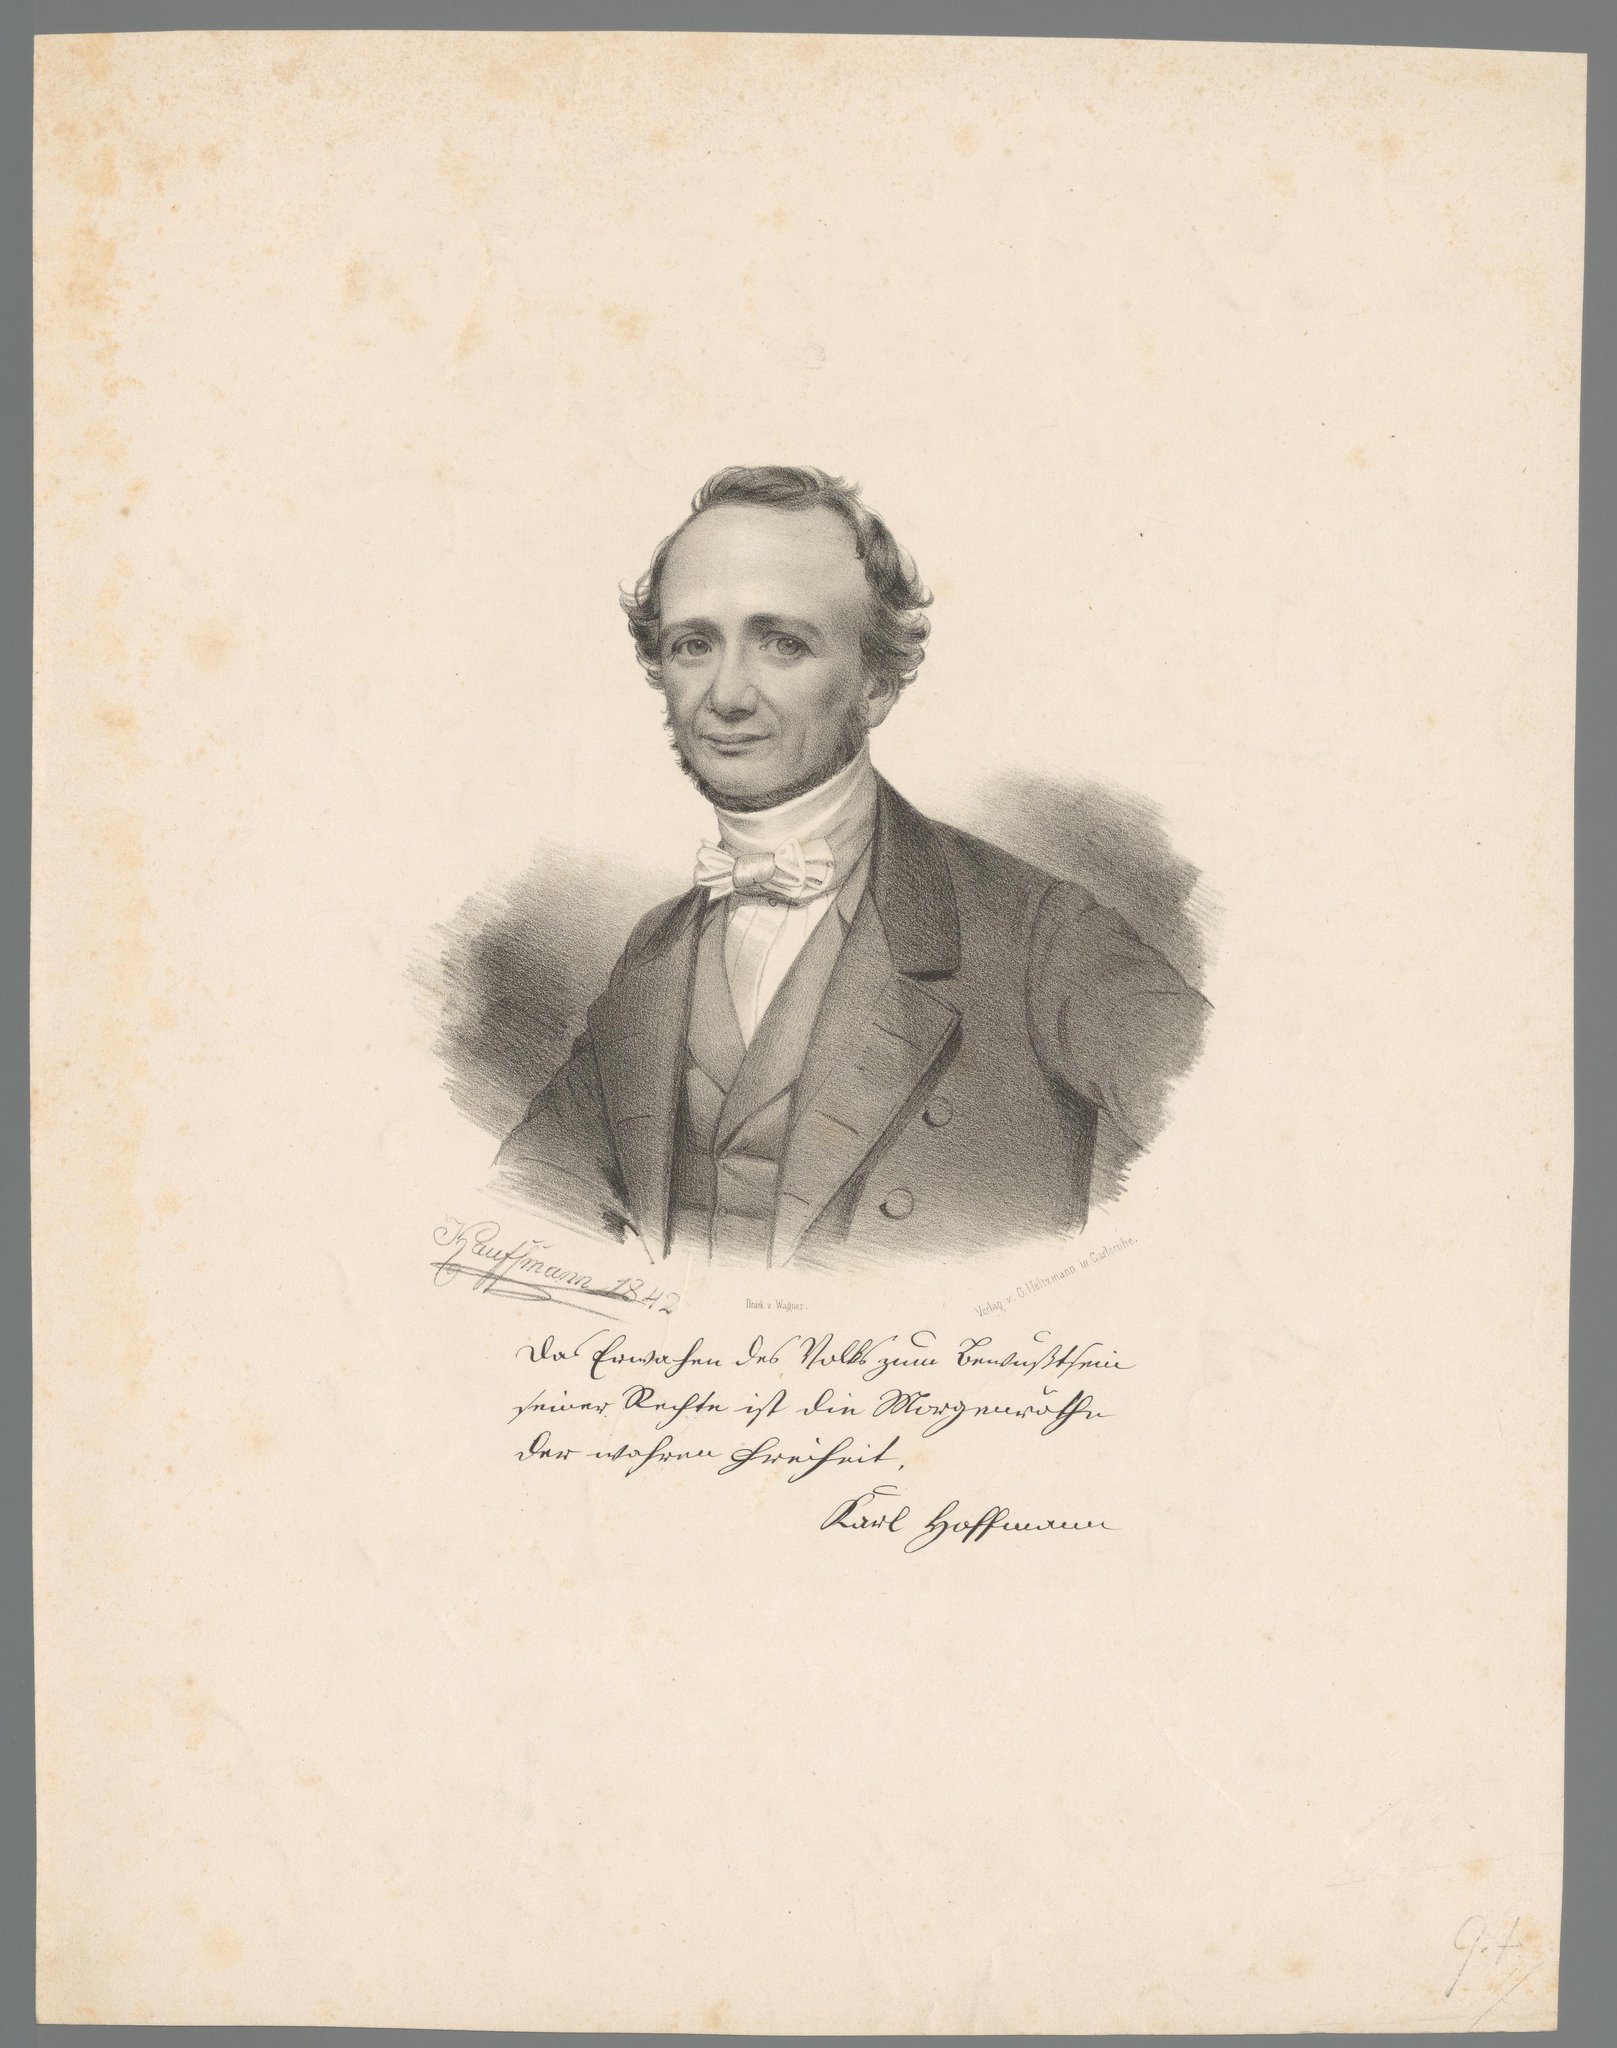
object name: print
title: Portret van Carl Hoffmann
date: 1842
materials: paper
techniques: lithograph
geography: karlsruhe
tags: adult man, historical persons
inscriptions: collector's mark: Lugt 2228